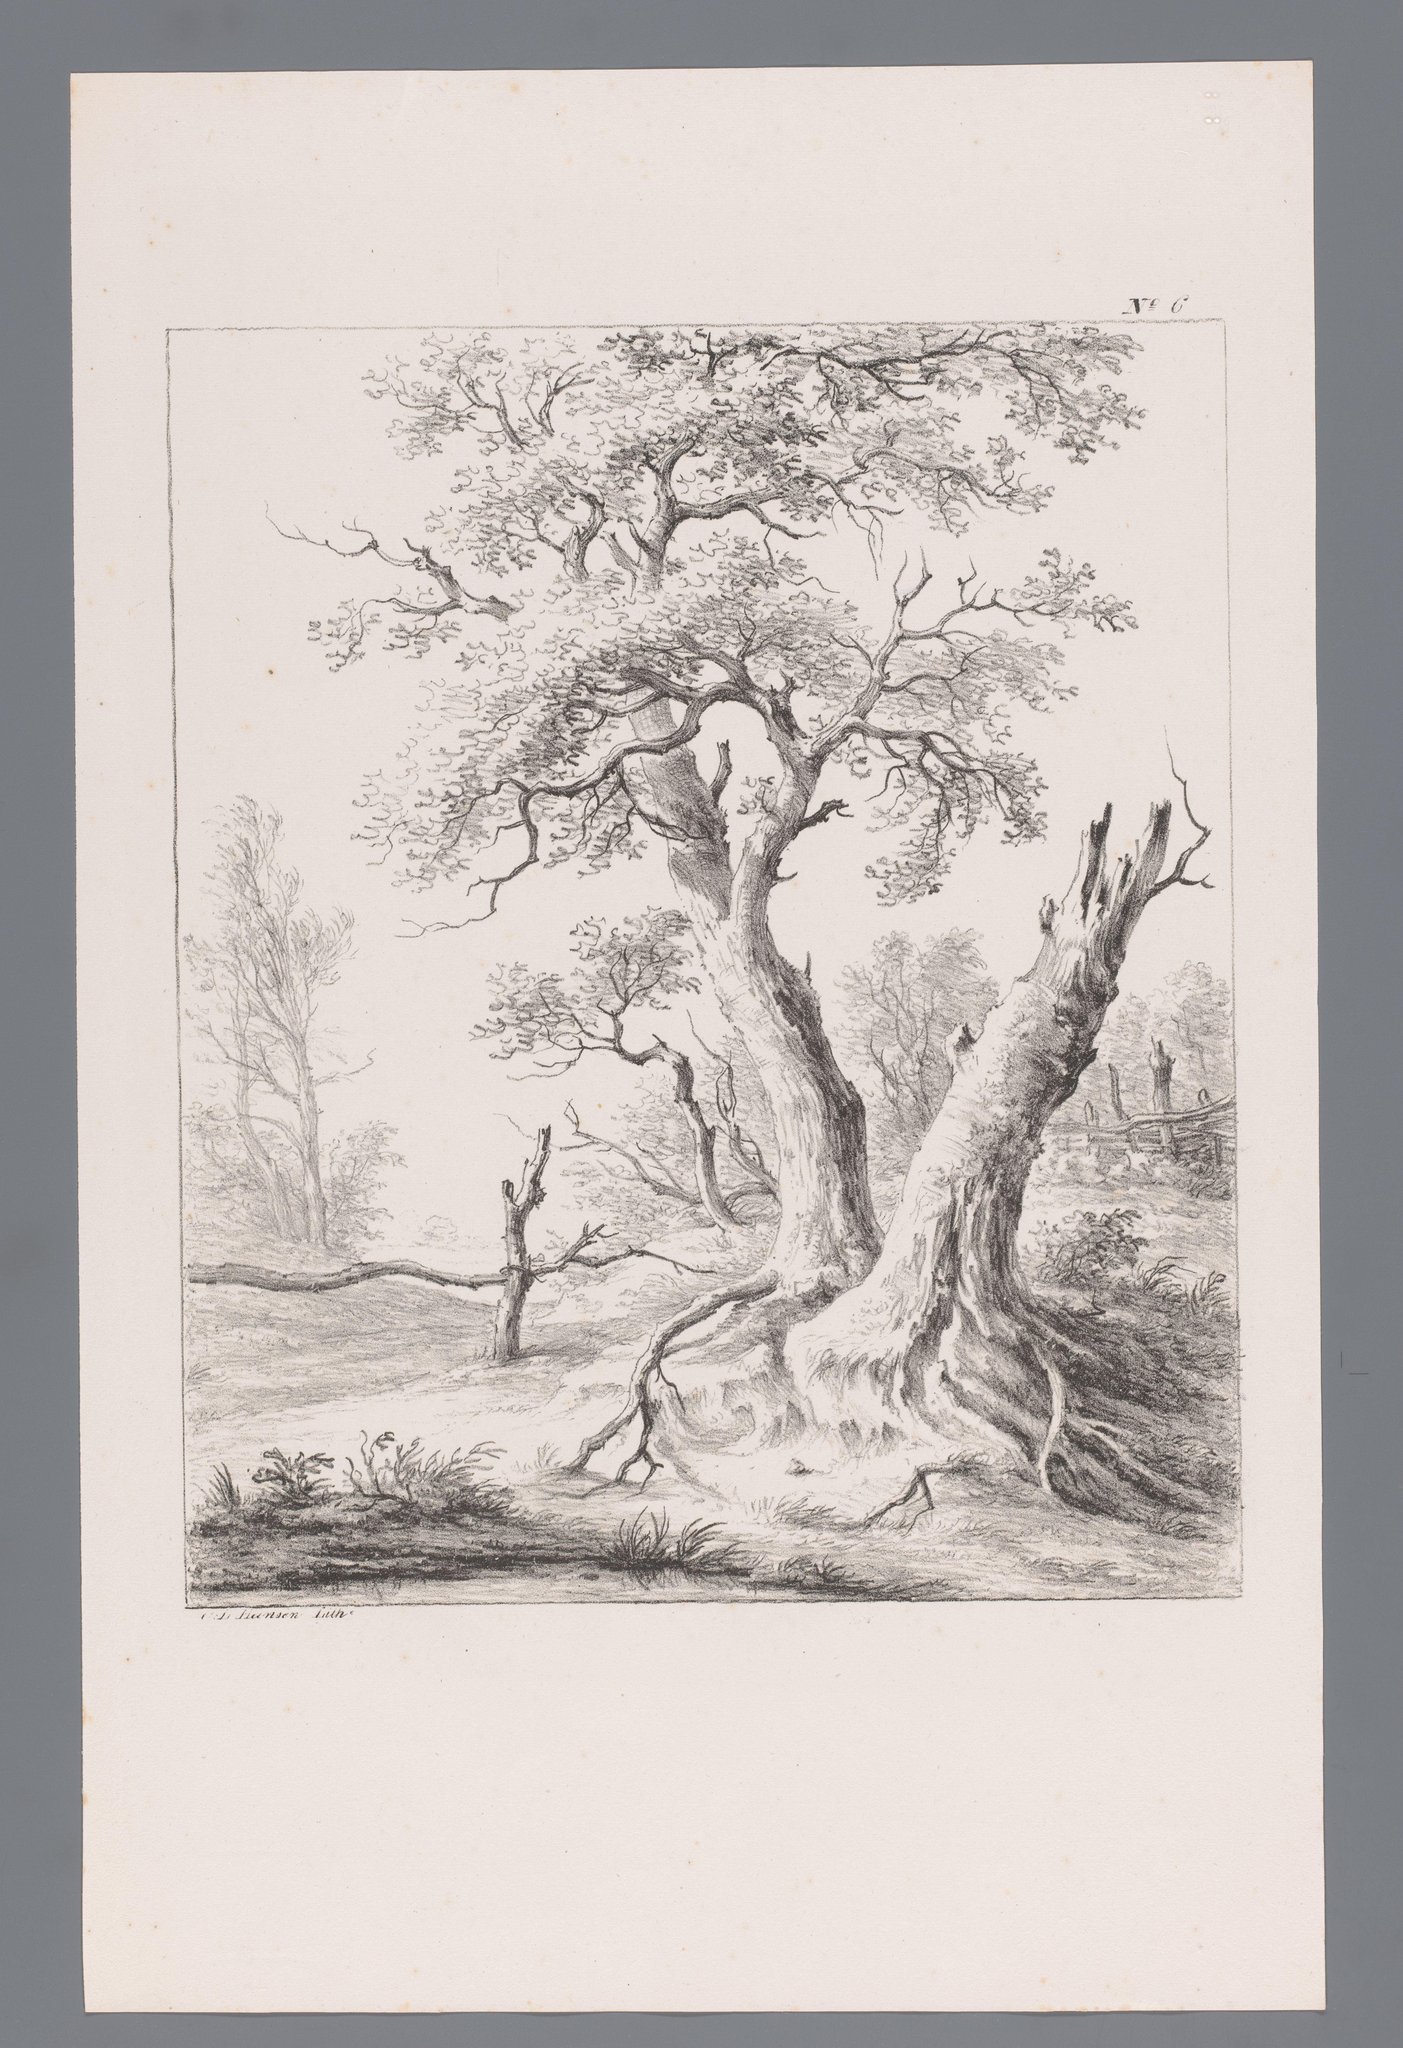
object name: print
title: Gezonde en dode boom in landschap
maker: carel lodewijk hansen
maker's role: draughtsman, painter, print maker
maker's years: 1765-1840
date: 1809-1840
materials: paper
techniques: lithograph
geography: netherlands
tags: trees, groups of trees, trees (+ stump, stub)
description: De dode boom bestaat uit een afgebroken stam. De bomen staan naast een slagboom. Maakt deel uit van een omslag met zes prenten.